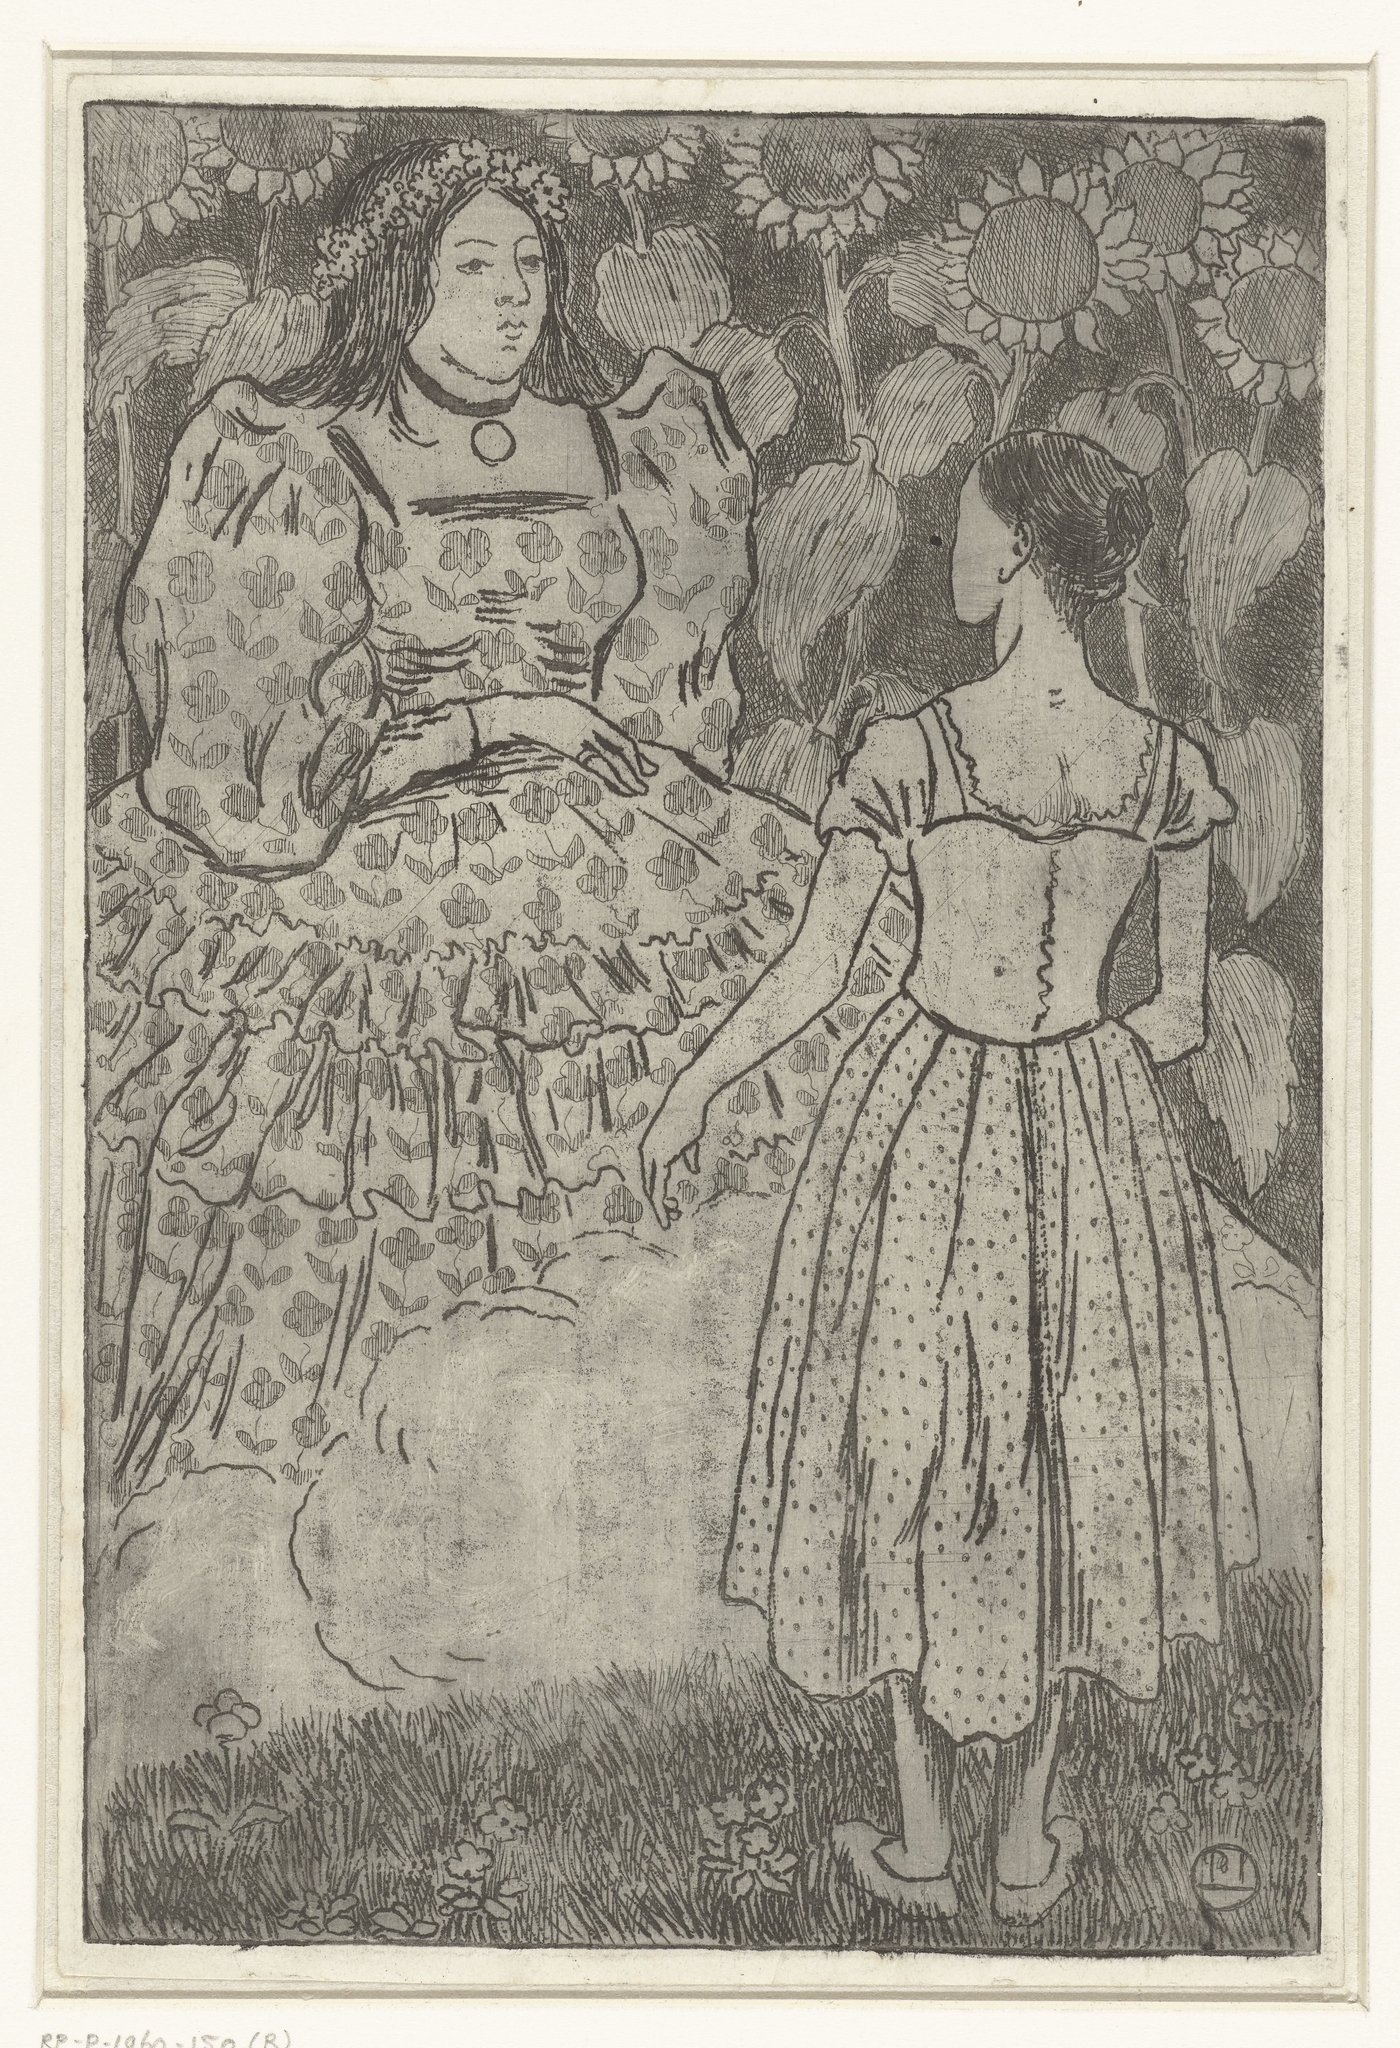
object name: print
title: Fee verschijnt aan Assepoester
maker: lucien pissarro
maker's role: painter, print maker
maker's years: 1863-1944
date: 1873-1944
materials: paper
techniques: aquatint, etching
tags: fairy, tales and fairy tales (with title)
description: De goede fee verschijnt in een wolk aan Assepoester ( Cinderella). Zonnebloemen op de achtergrond. Scène uit het sprookje van Assepoester.